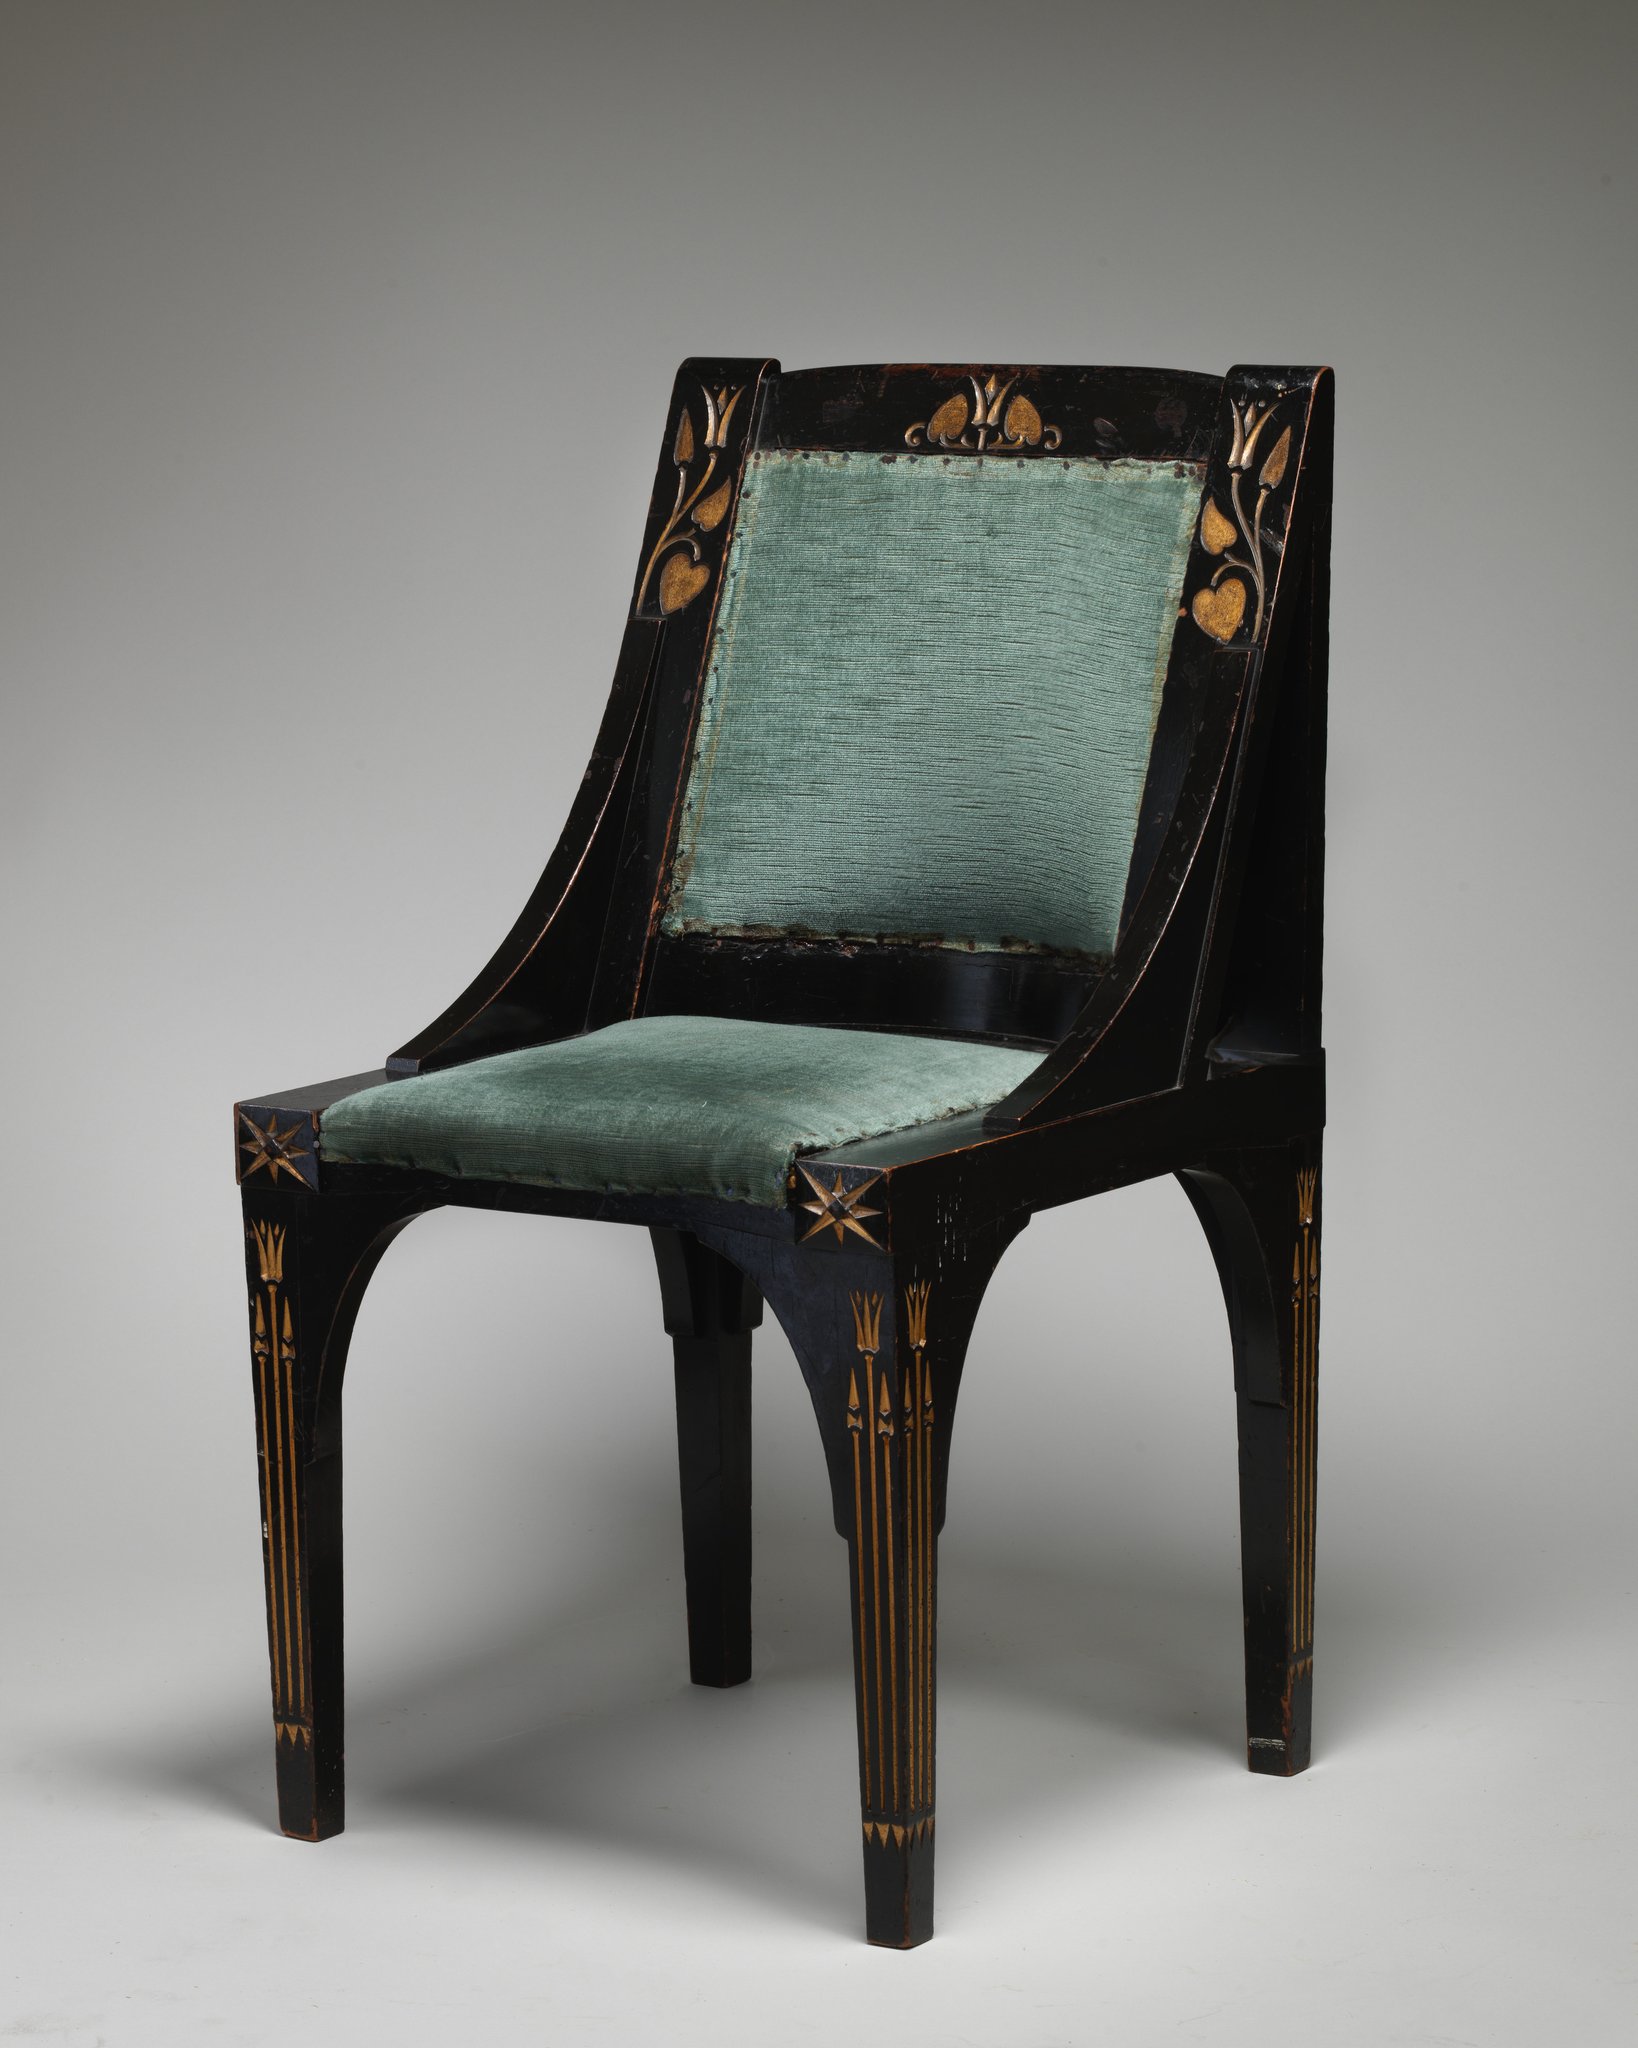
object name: side chair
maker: christopher dresser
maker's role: designer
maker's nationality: british, scottish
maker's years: 1834-1904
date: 1870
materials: gilt, wood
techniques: carving